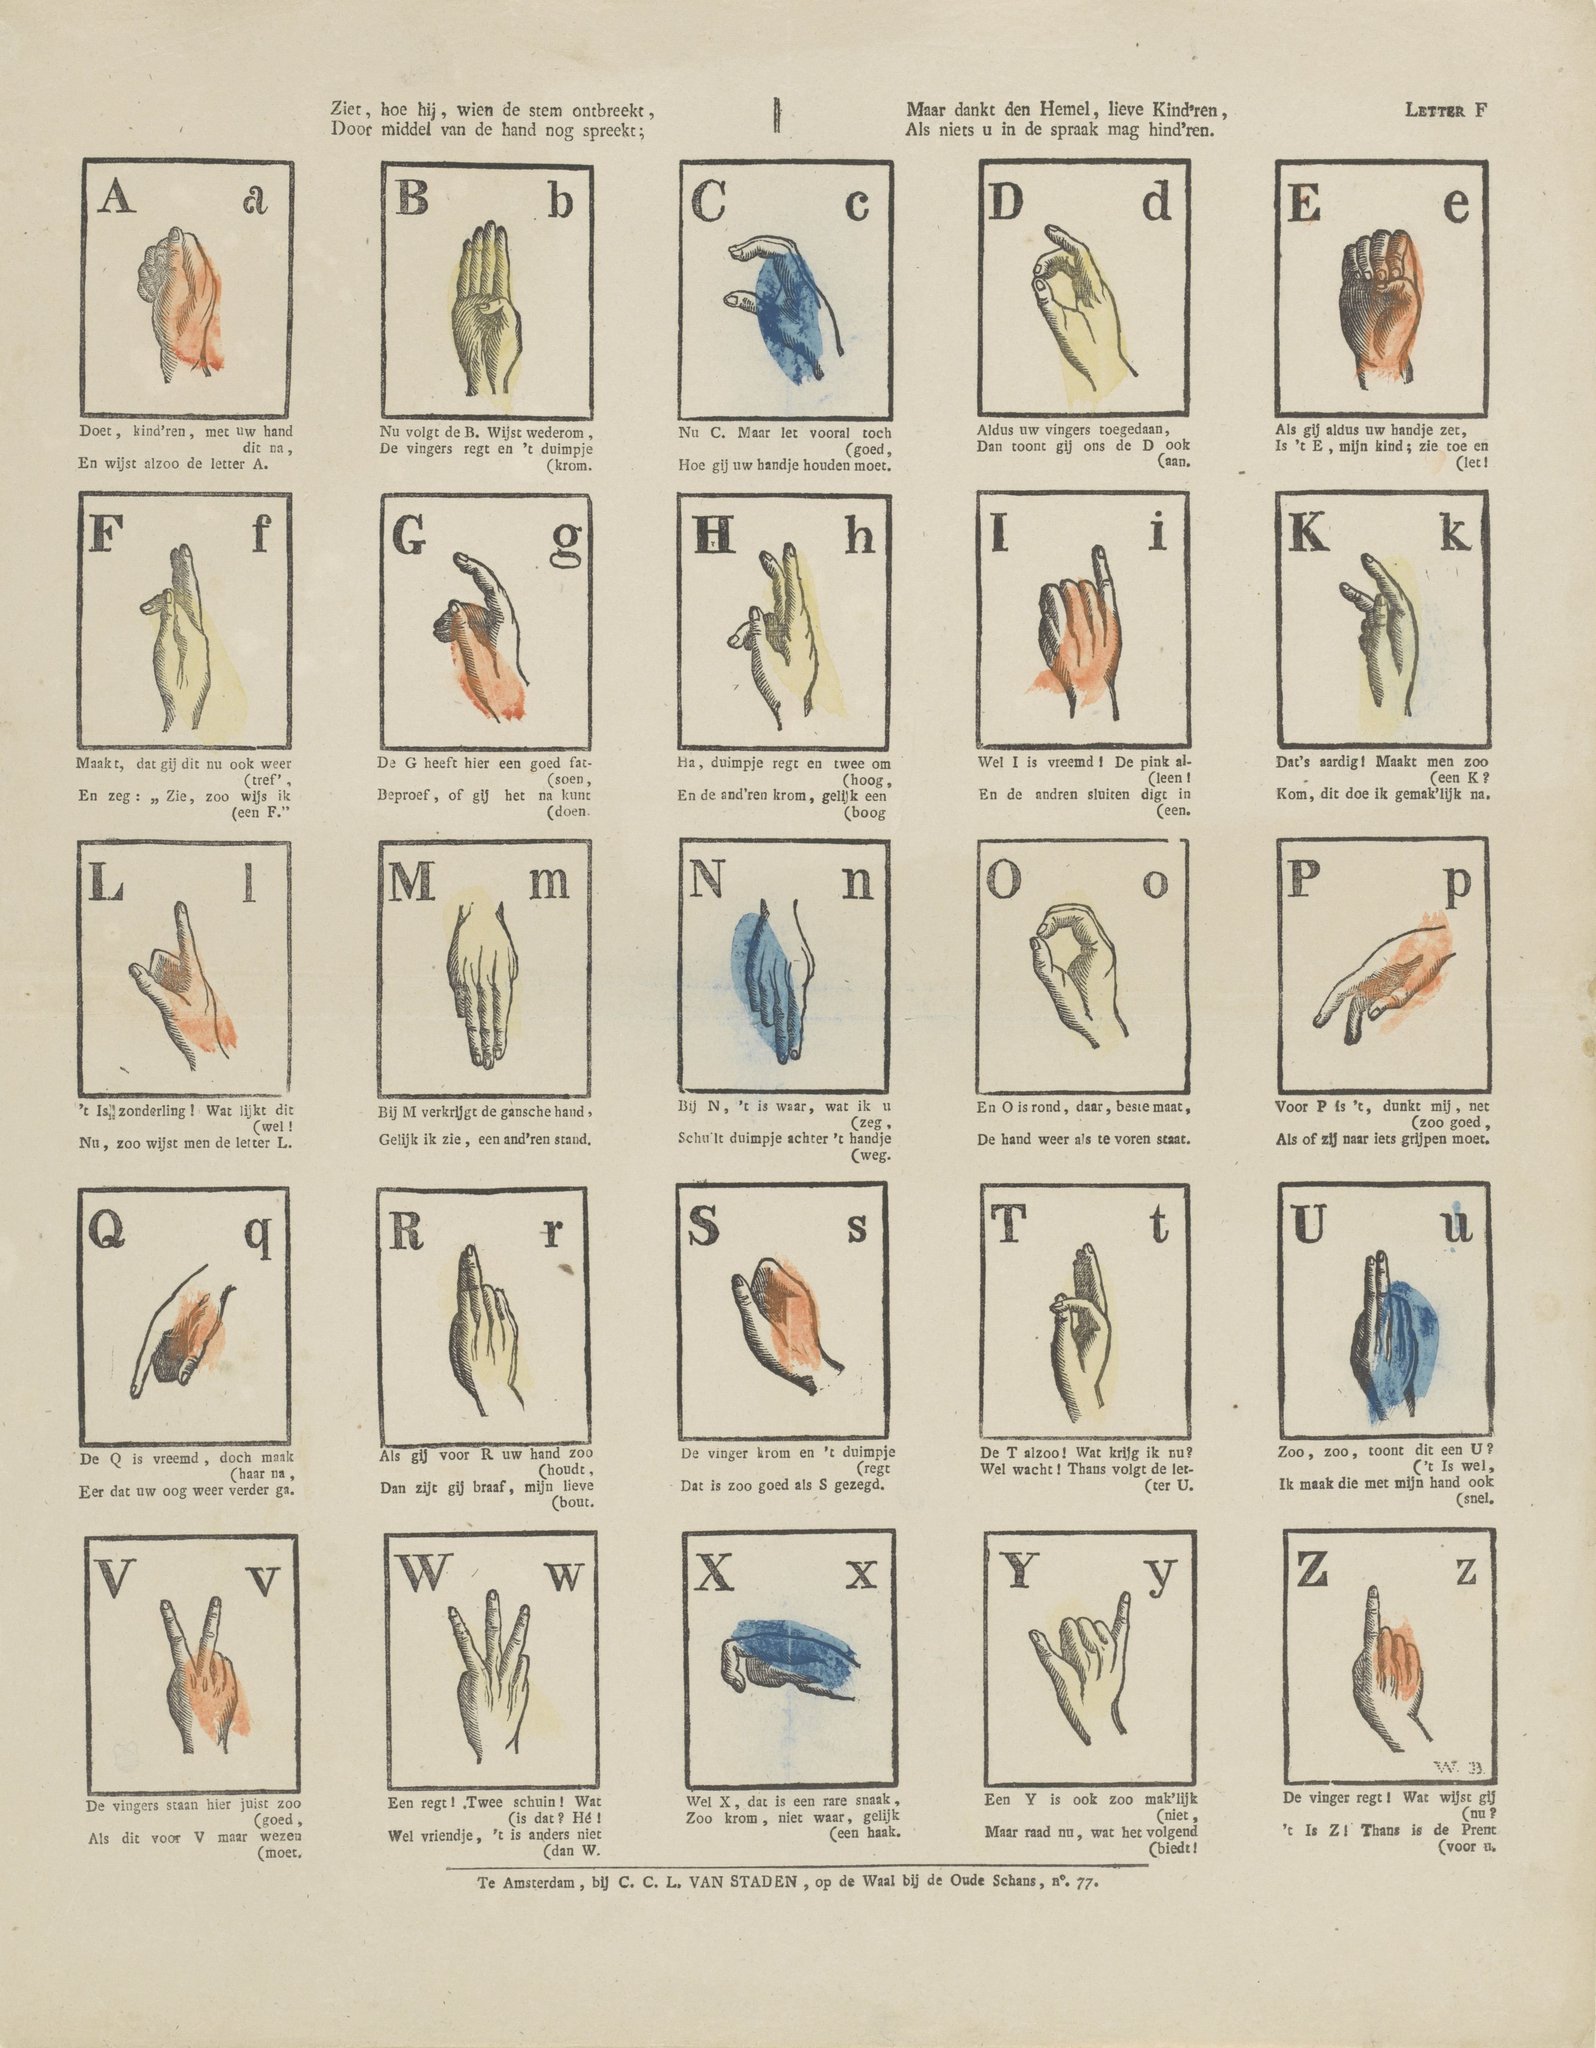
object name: popular print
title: Ziet, hoe hij, wien de stem ontbreekt, / Door middel van de hand nog spreekt; / Maar dankt den hemel, lieve kind'ren, / Als niets u in de spraak mag hind'ren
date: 1822-1870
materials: paper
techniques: colour, letterpress printing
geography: amsterdam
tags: letters, alphabet, script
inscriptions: collector's mark: Lugt 2760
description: Blad met 25 voorstellingen van de letters van het alfabet geïllustreerd met handengebaren waarmee alle letters van een alfabet worden uitgebeeld (handalfabet). Onder elke voorstelling een tweeregelig vers. Rechtsboven gemerkt: Letter F.